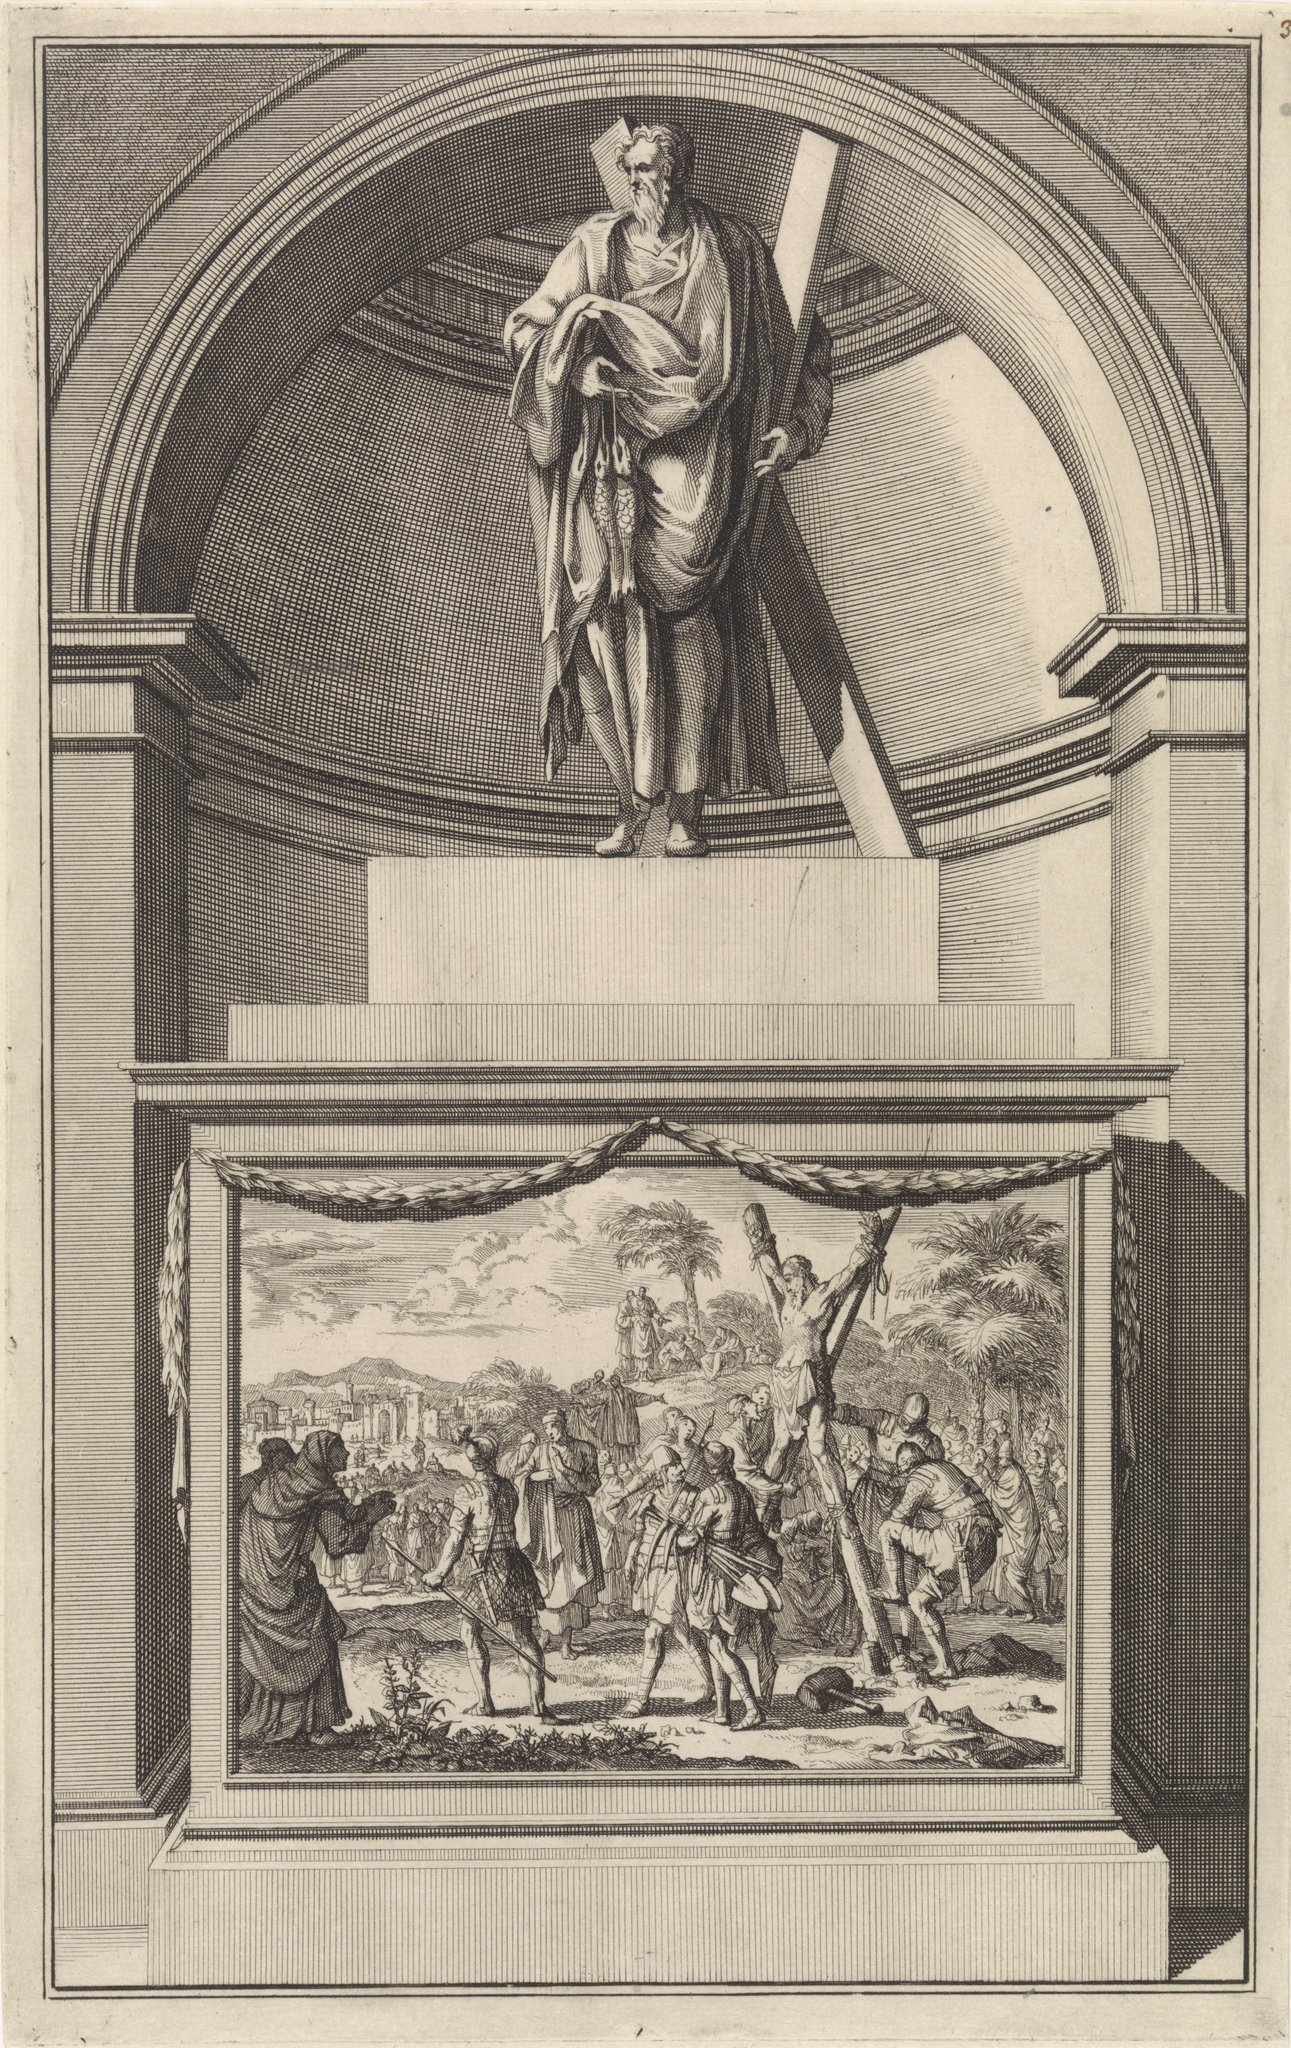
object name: print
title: Apostel Andreas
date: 1698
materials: paper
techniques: engraving, etching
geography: amsterdam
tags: the apostle andrew; possible attributes: book, x-shaped cross, fish, fishing-net, rope, scroll, crucifixion of andrew: he is undressed and tied to the cross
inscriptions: number: ‘3’, collector's mark: Lugt 2228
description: Proefdruk van illustratie uit: Cave, William. Apostolische oudheden, of Het leven (...) der heylige apostelen, 3 delen. Utrecht: François Halma en Willem van de Water (I), 1698, p. 272.